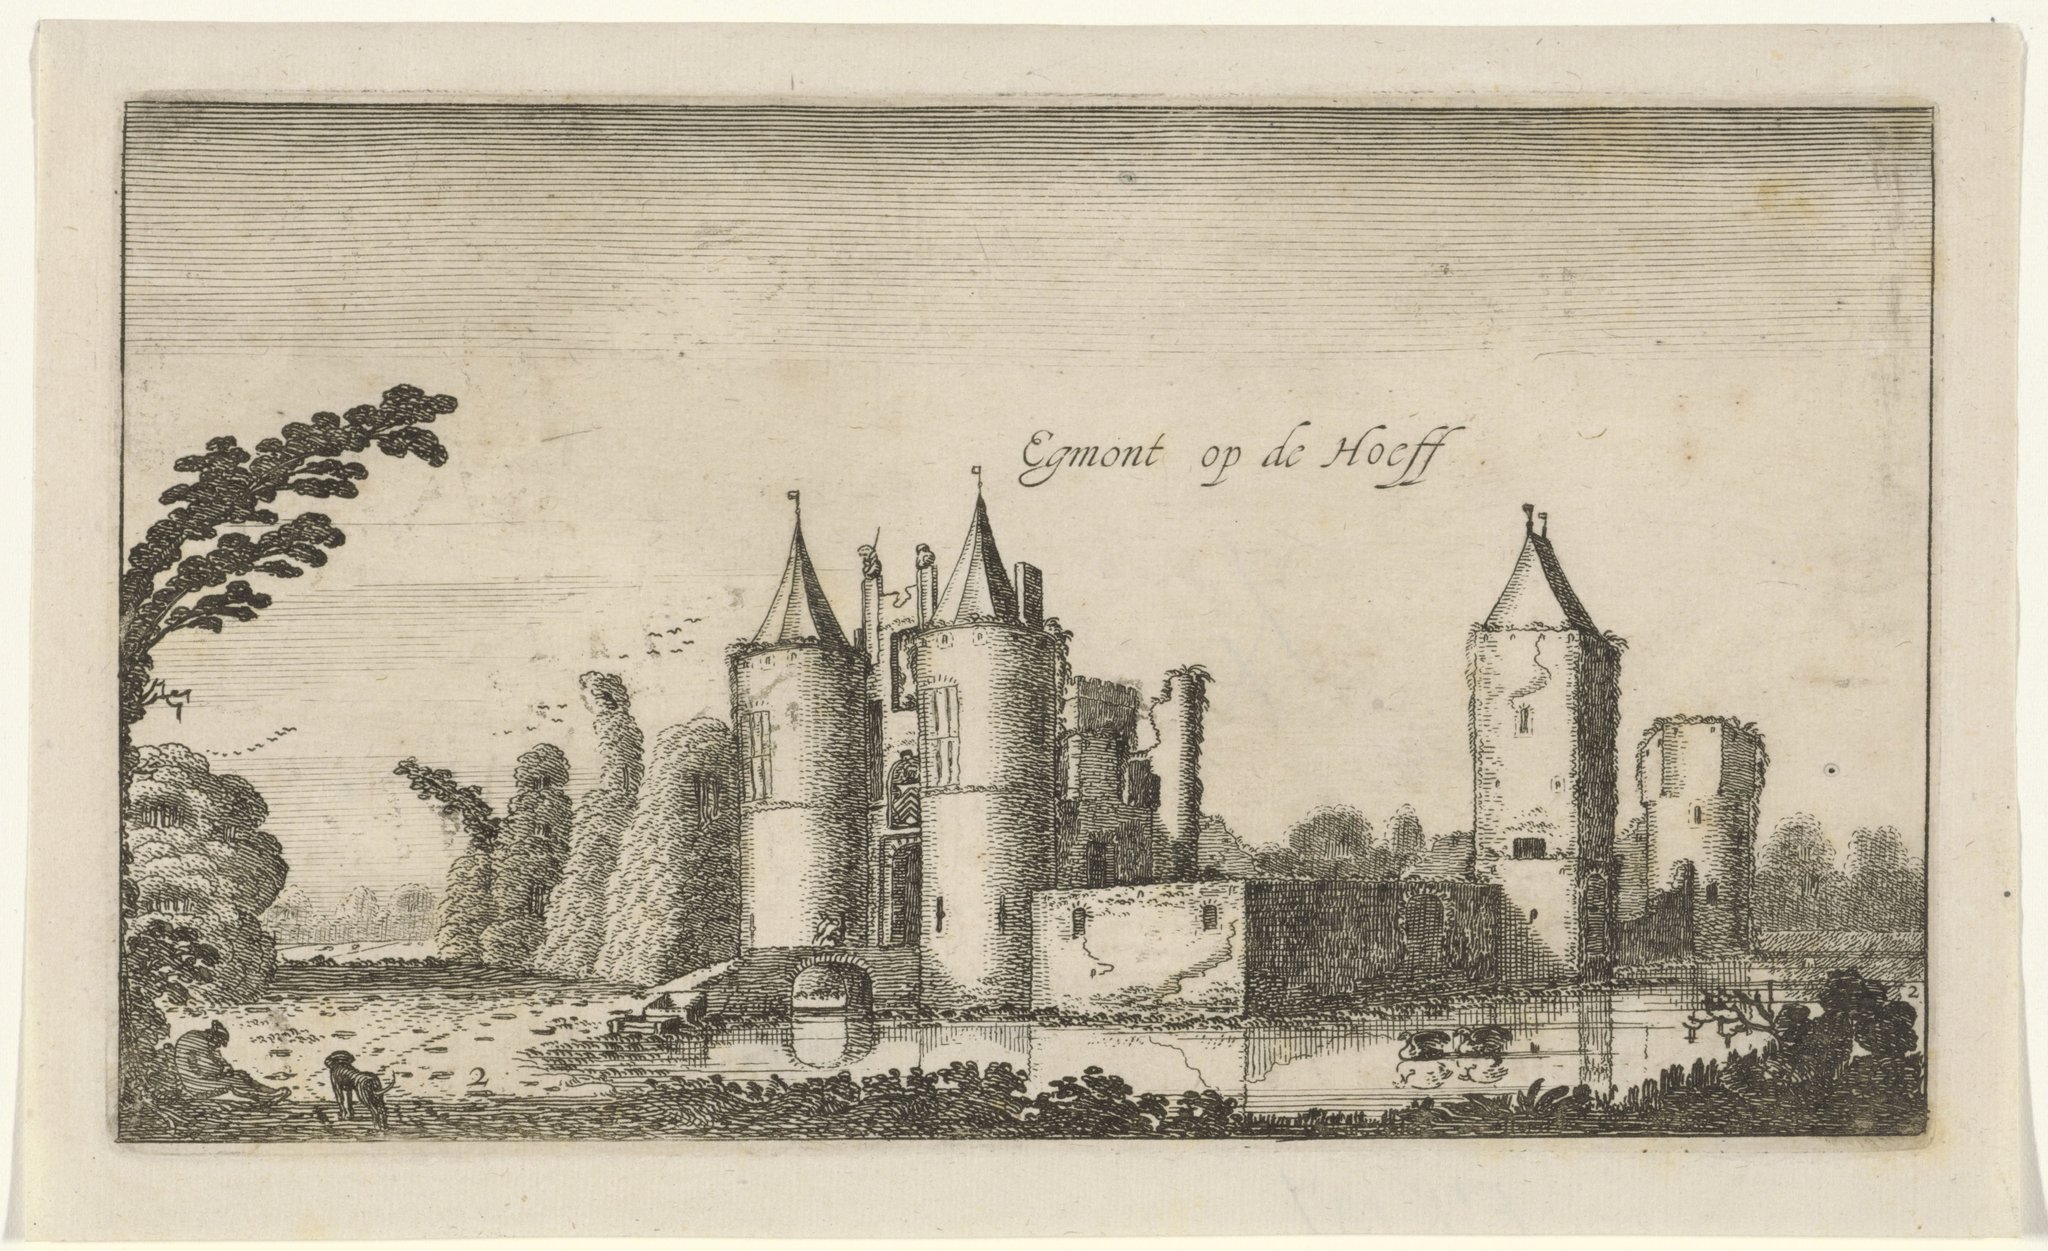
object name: print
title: Gezicht op de ruïne van het kasteel van Egmond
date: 1616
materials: paper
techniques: etching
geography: northern netherlands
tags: landscape with ruins, landscape with tower or castle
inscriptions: collector's mark: Lugt 964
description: Ruïne van het kasteel van Egmond, waarvan de poort nog overeind staat, op de voorgrond links een man met een hond. Tweede prent uit een serie van zes.